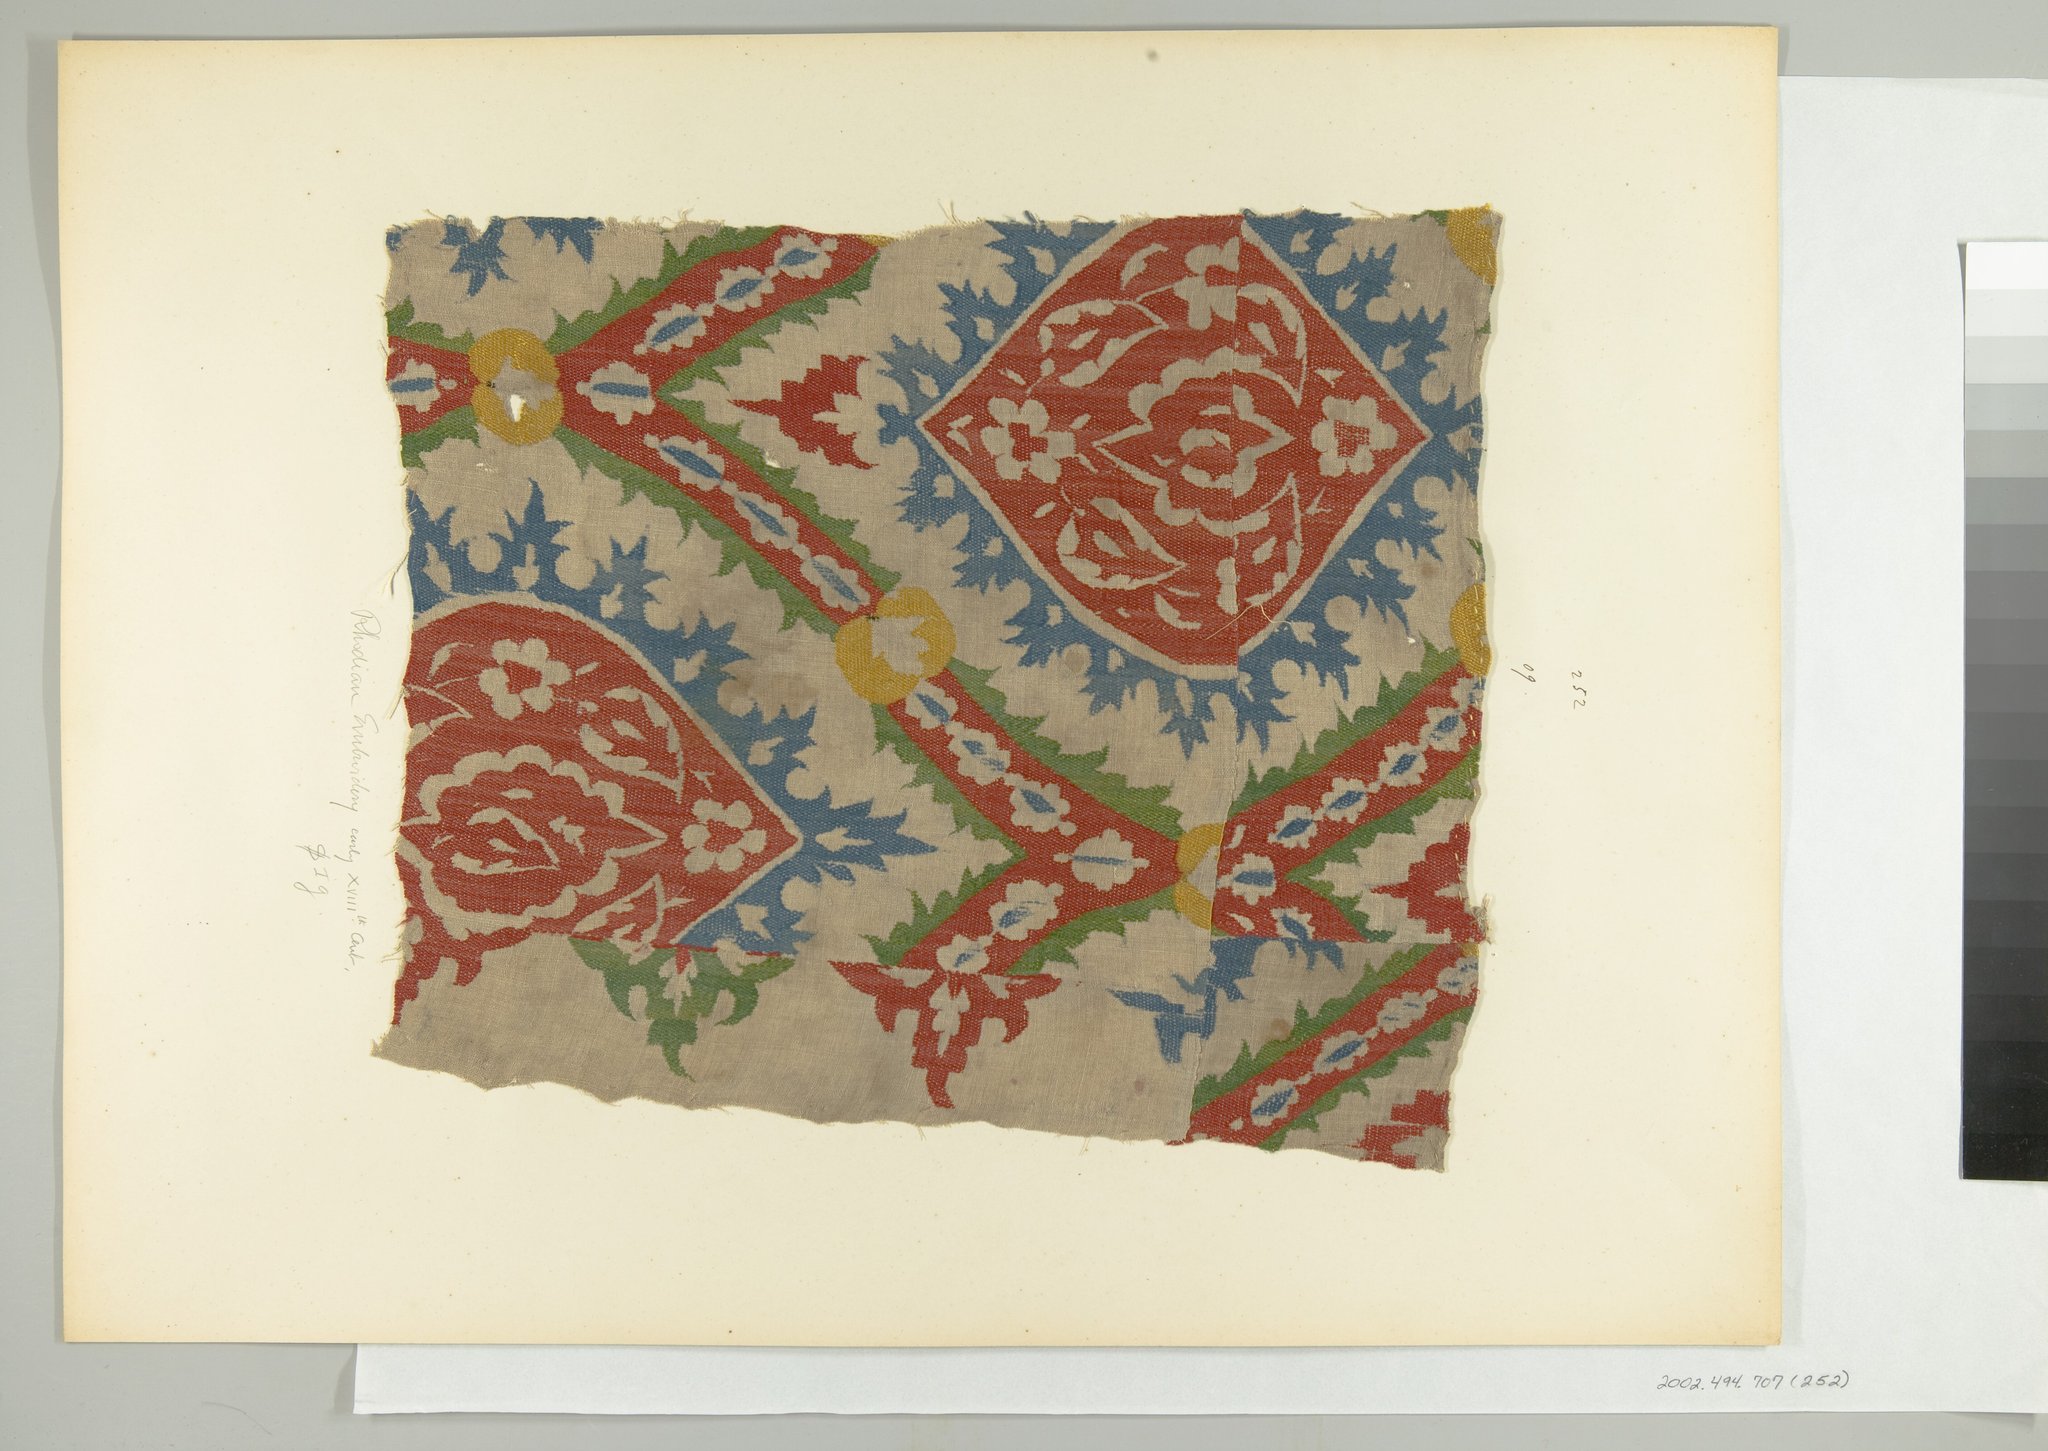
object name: textile fragment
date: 1701-1800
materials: cotton, silk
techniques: embroidery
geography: turkey